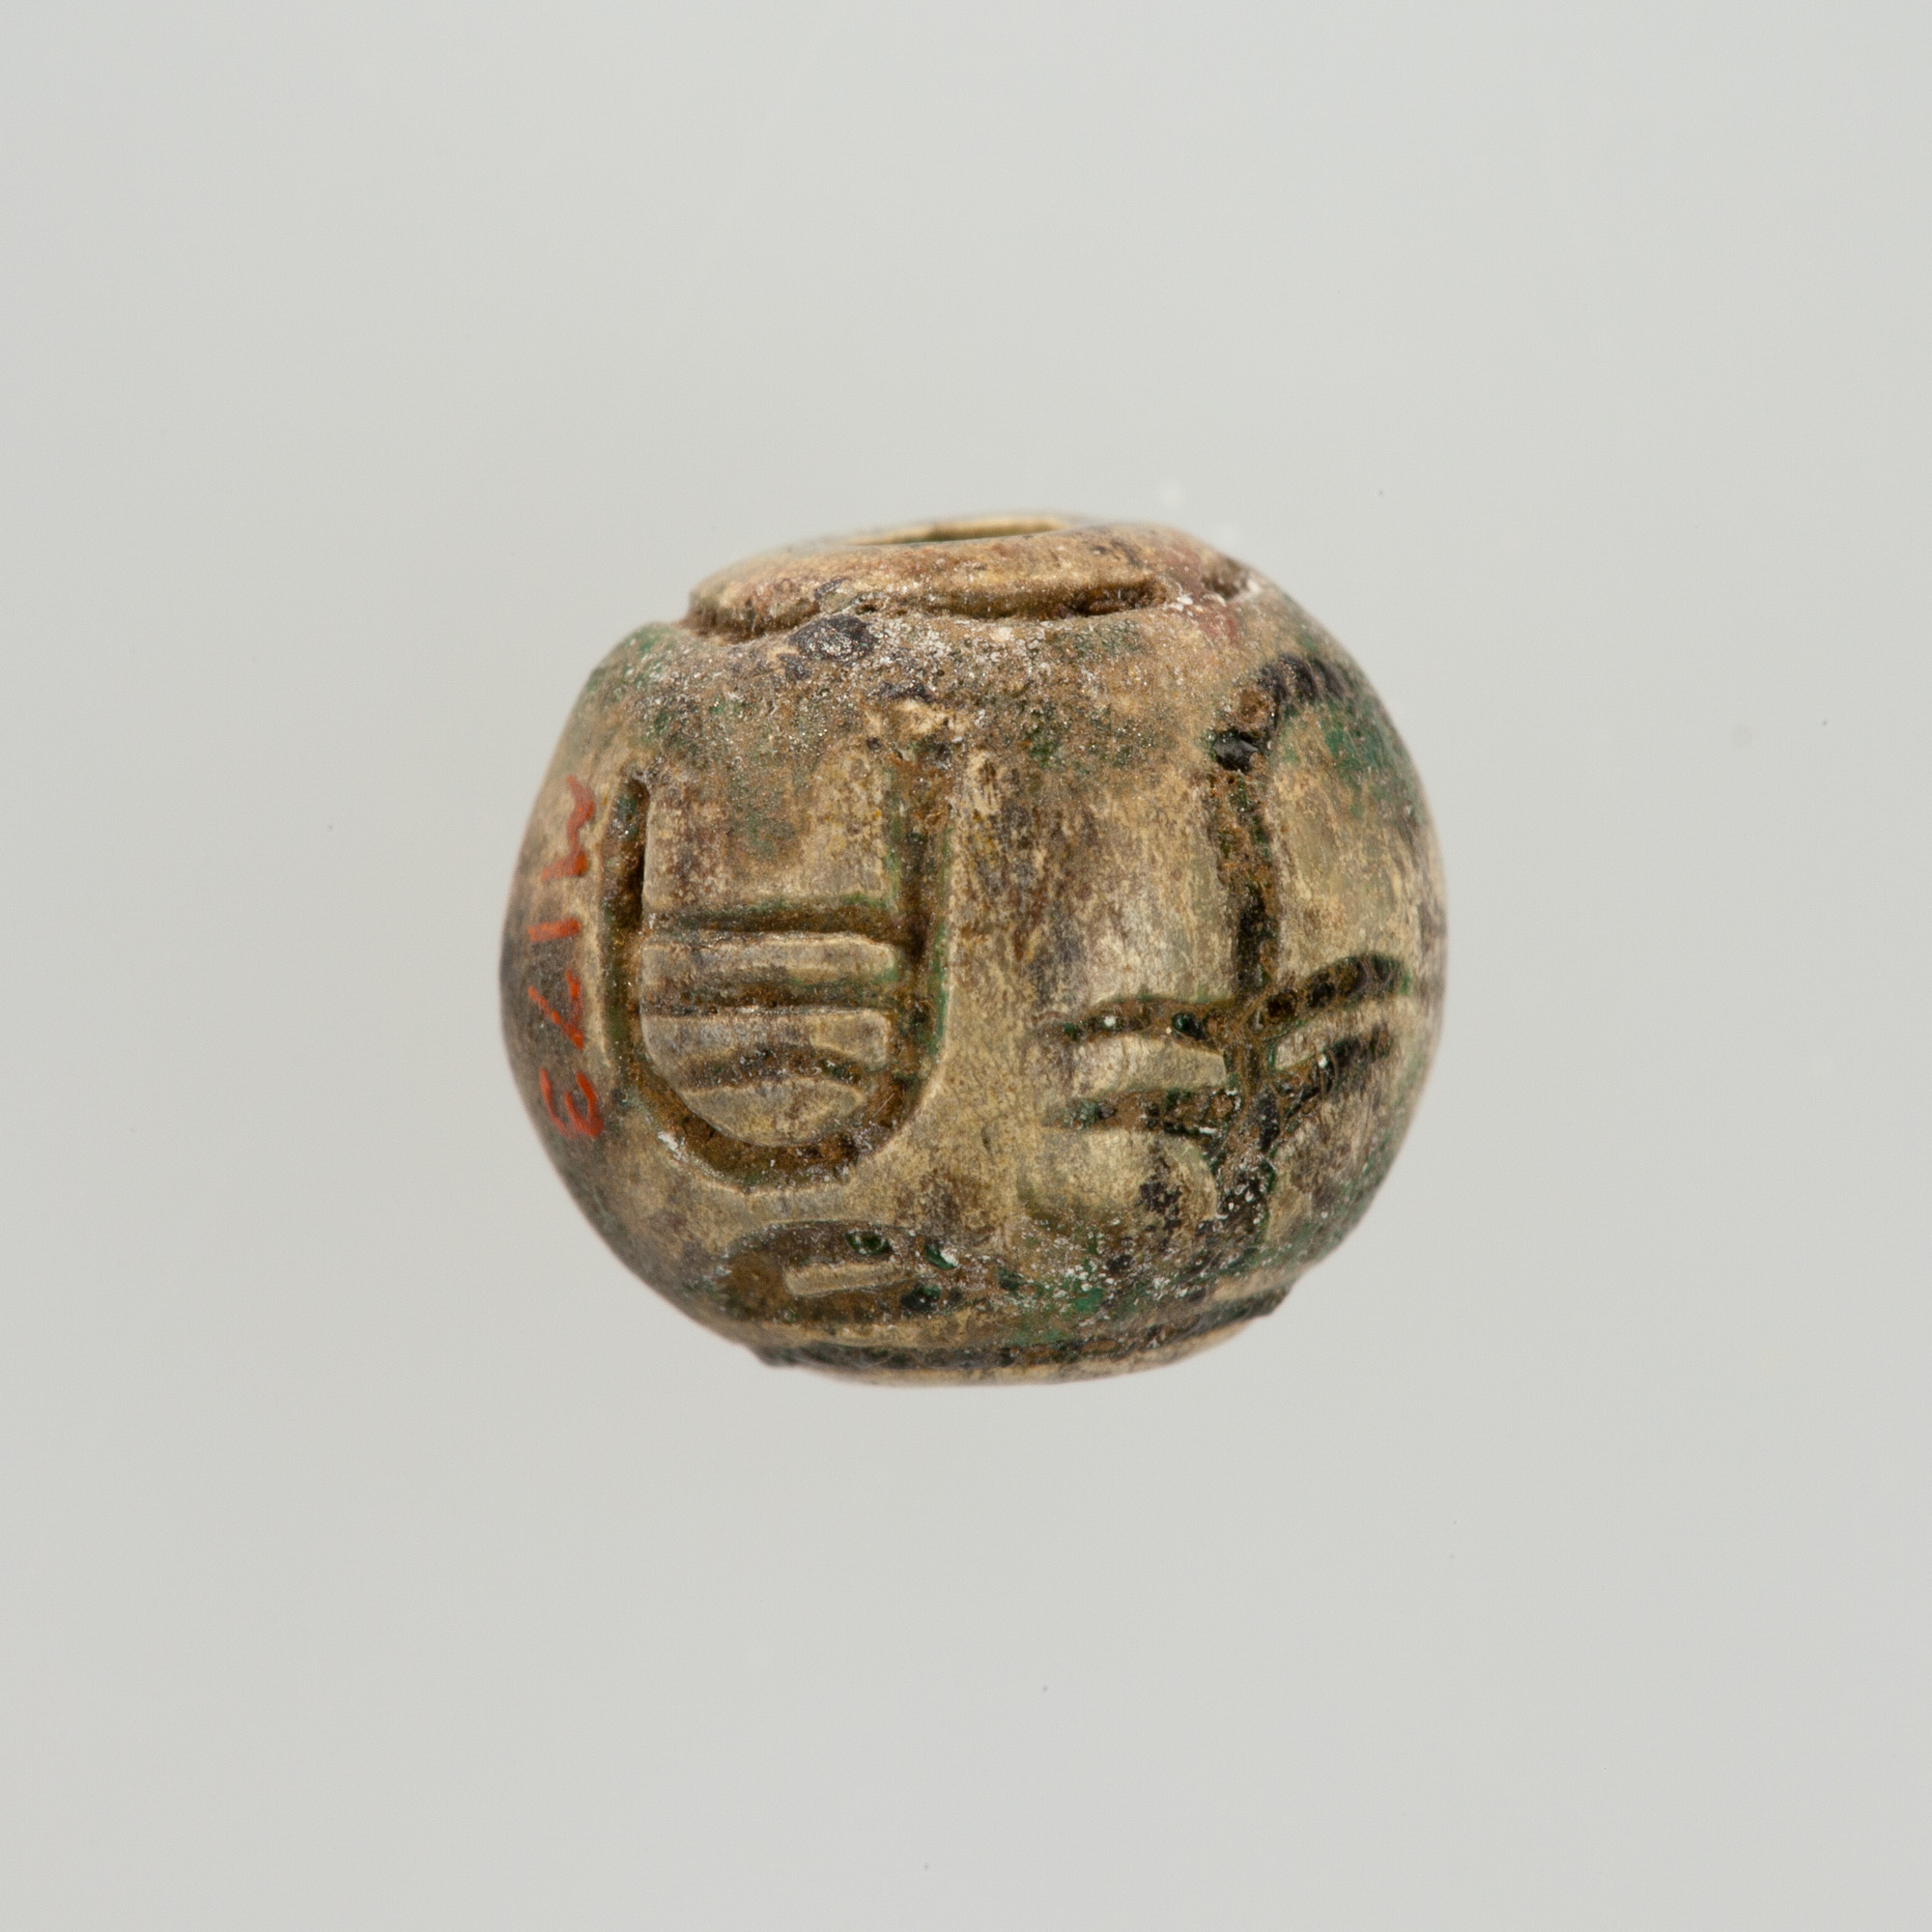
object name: bead, ahmose nefertari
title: Bead Inscribed with the Name Nefertari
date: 1550-1525 BCE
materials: stone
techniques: glazing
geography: egypt